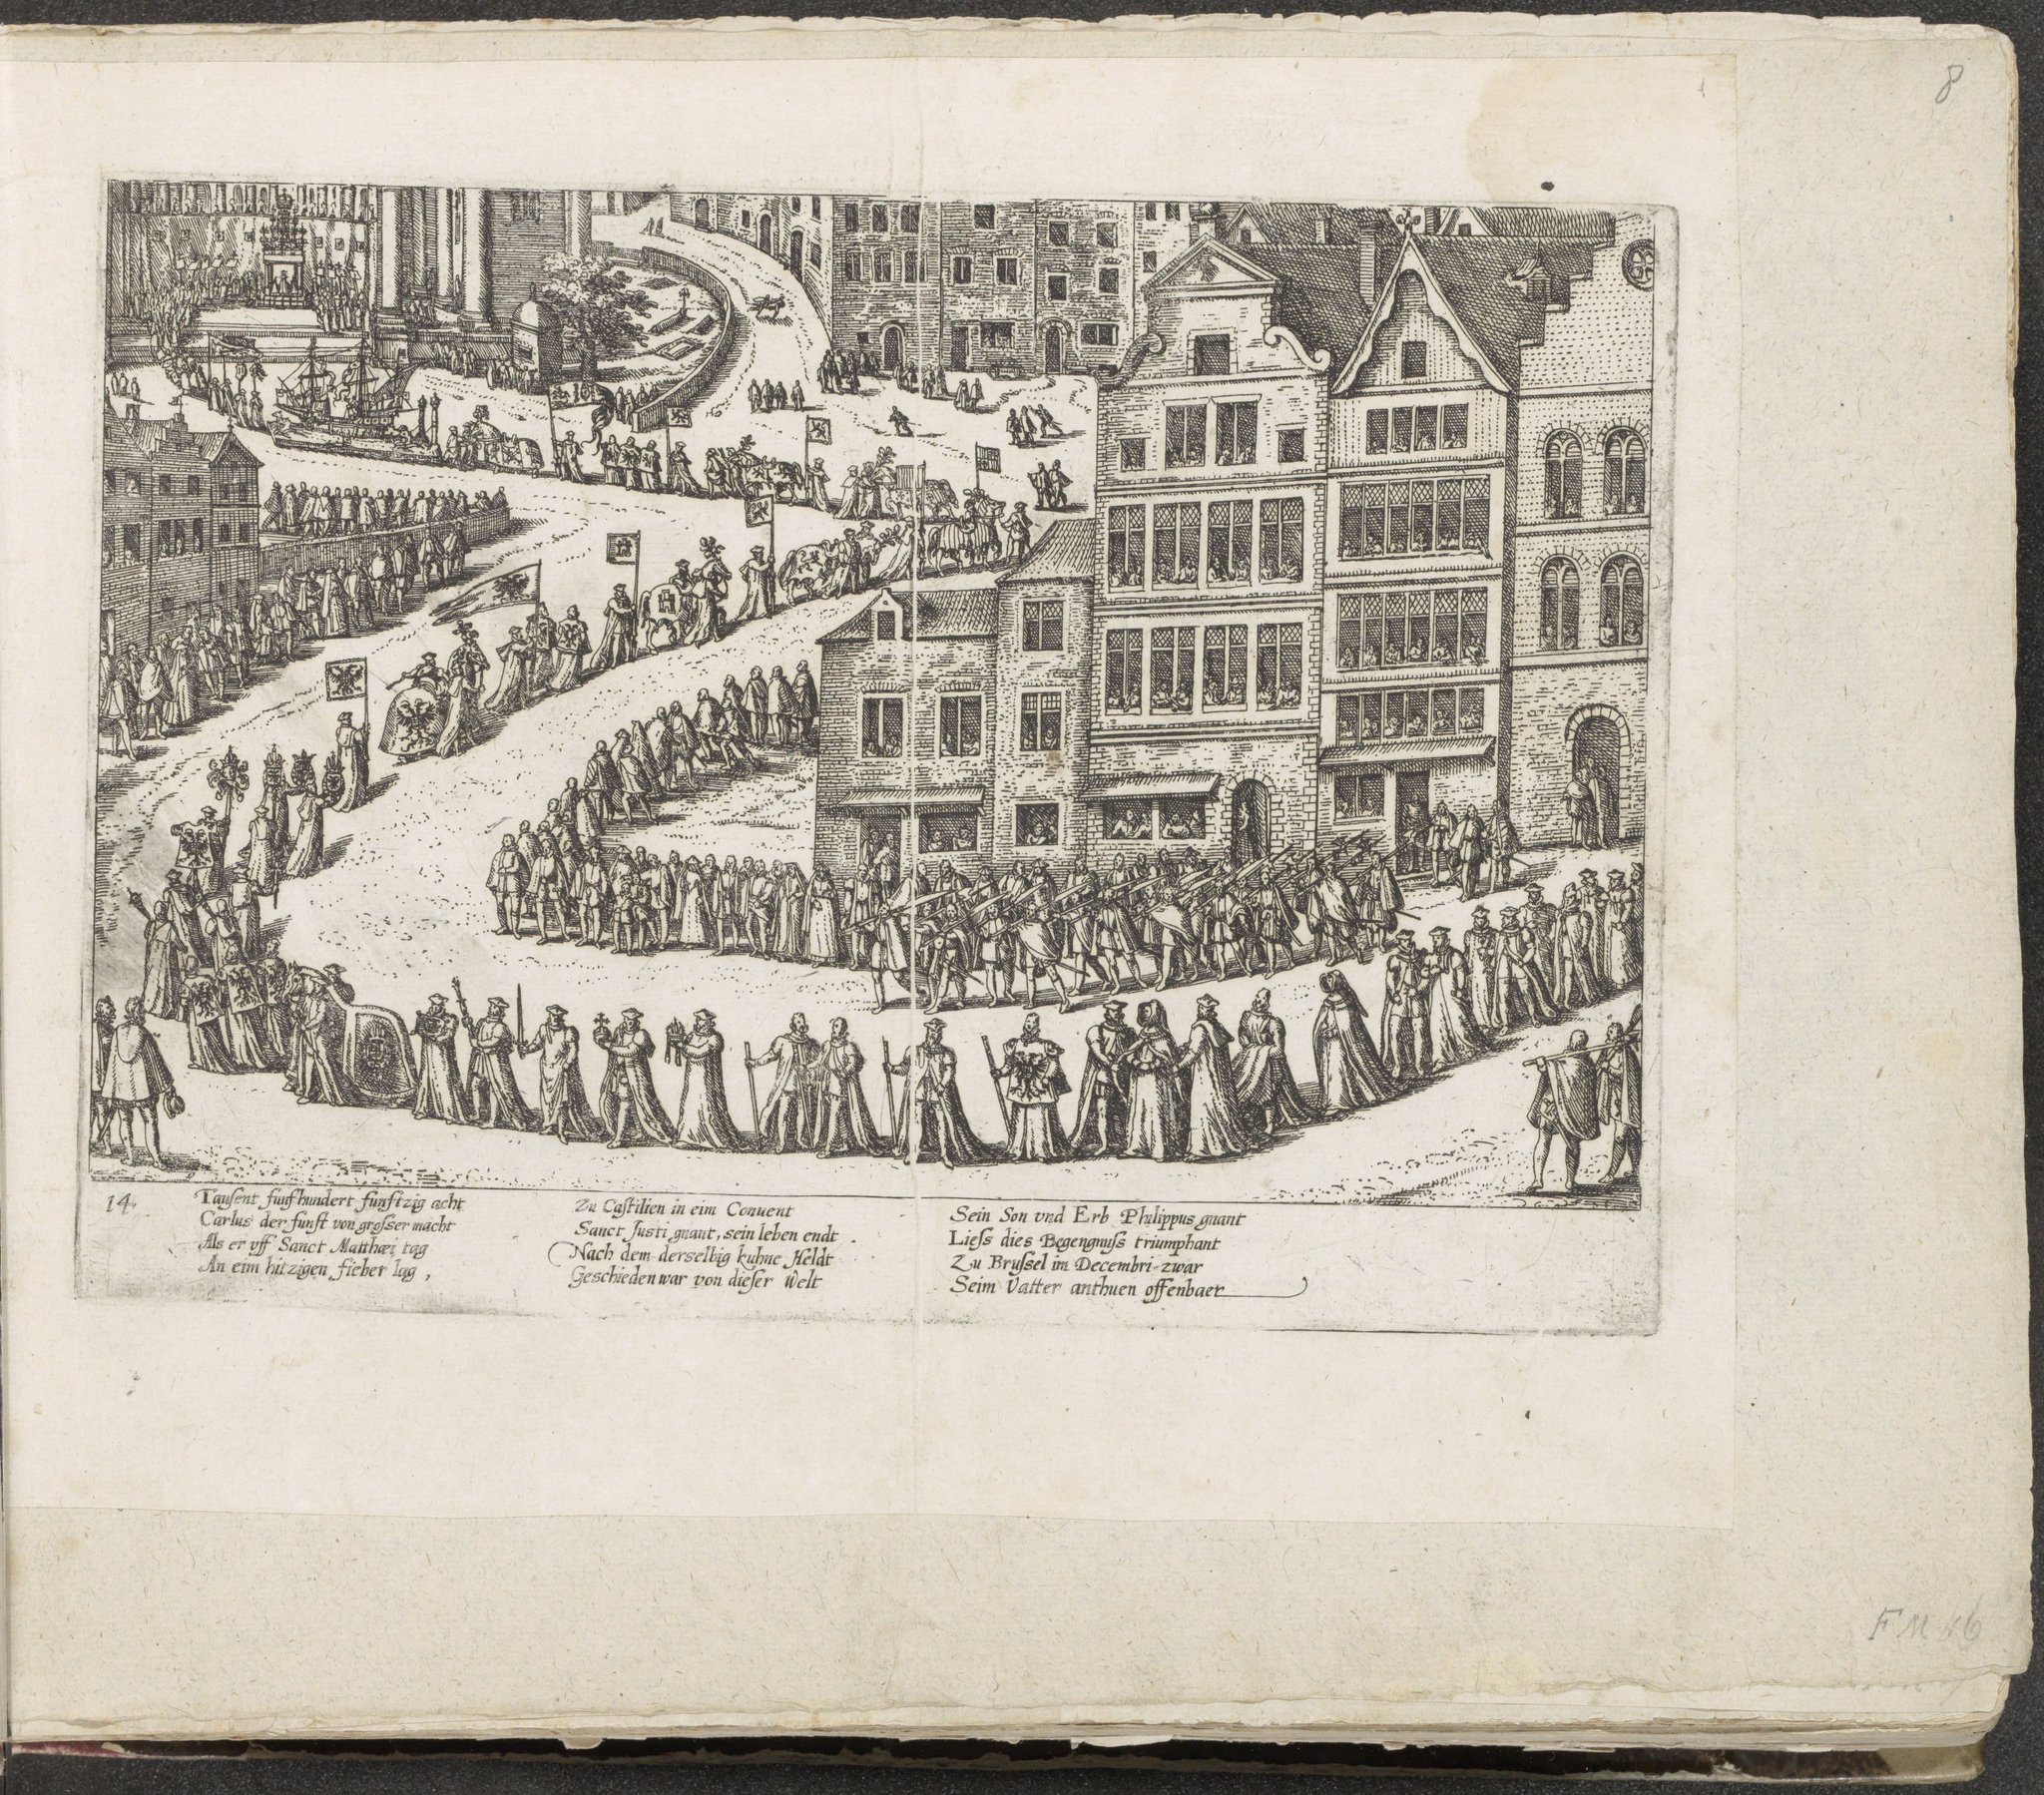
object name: history print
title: Lijkstatie van keizer Karel V, 1558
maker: frans hogenberg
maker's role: print maker, publisher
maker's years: 1538-1590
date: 1568-1572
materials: paper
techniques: etching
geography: cologne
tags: ghent, charles v (holy roman emperor and king of spain), cortege, funeral procession, brussels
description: Begrafenisoptocht van Karel V door de straten van Brussel op 29 december 1558. Een lange stoet van edelen en paarden trekt door de straten naar de kerk met de katafalk met kaarsen, vooraan de praalwagen met het schip Victoria. Op de voorgrond het deel van de stoet met Filips II in mantel met kap. Met onderschrift van 12 regels in het Duits. Linksonder genummerd: 14. De prent maakt deel uit van een album.